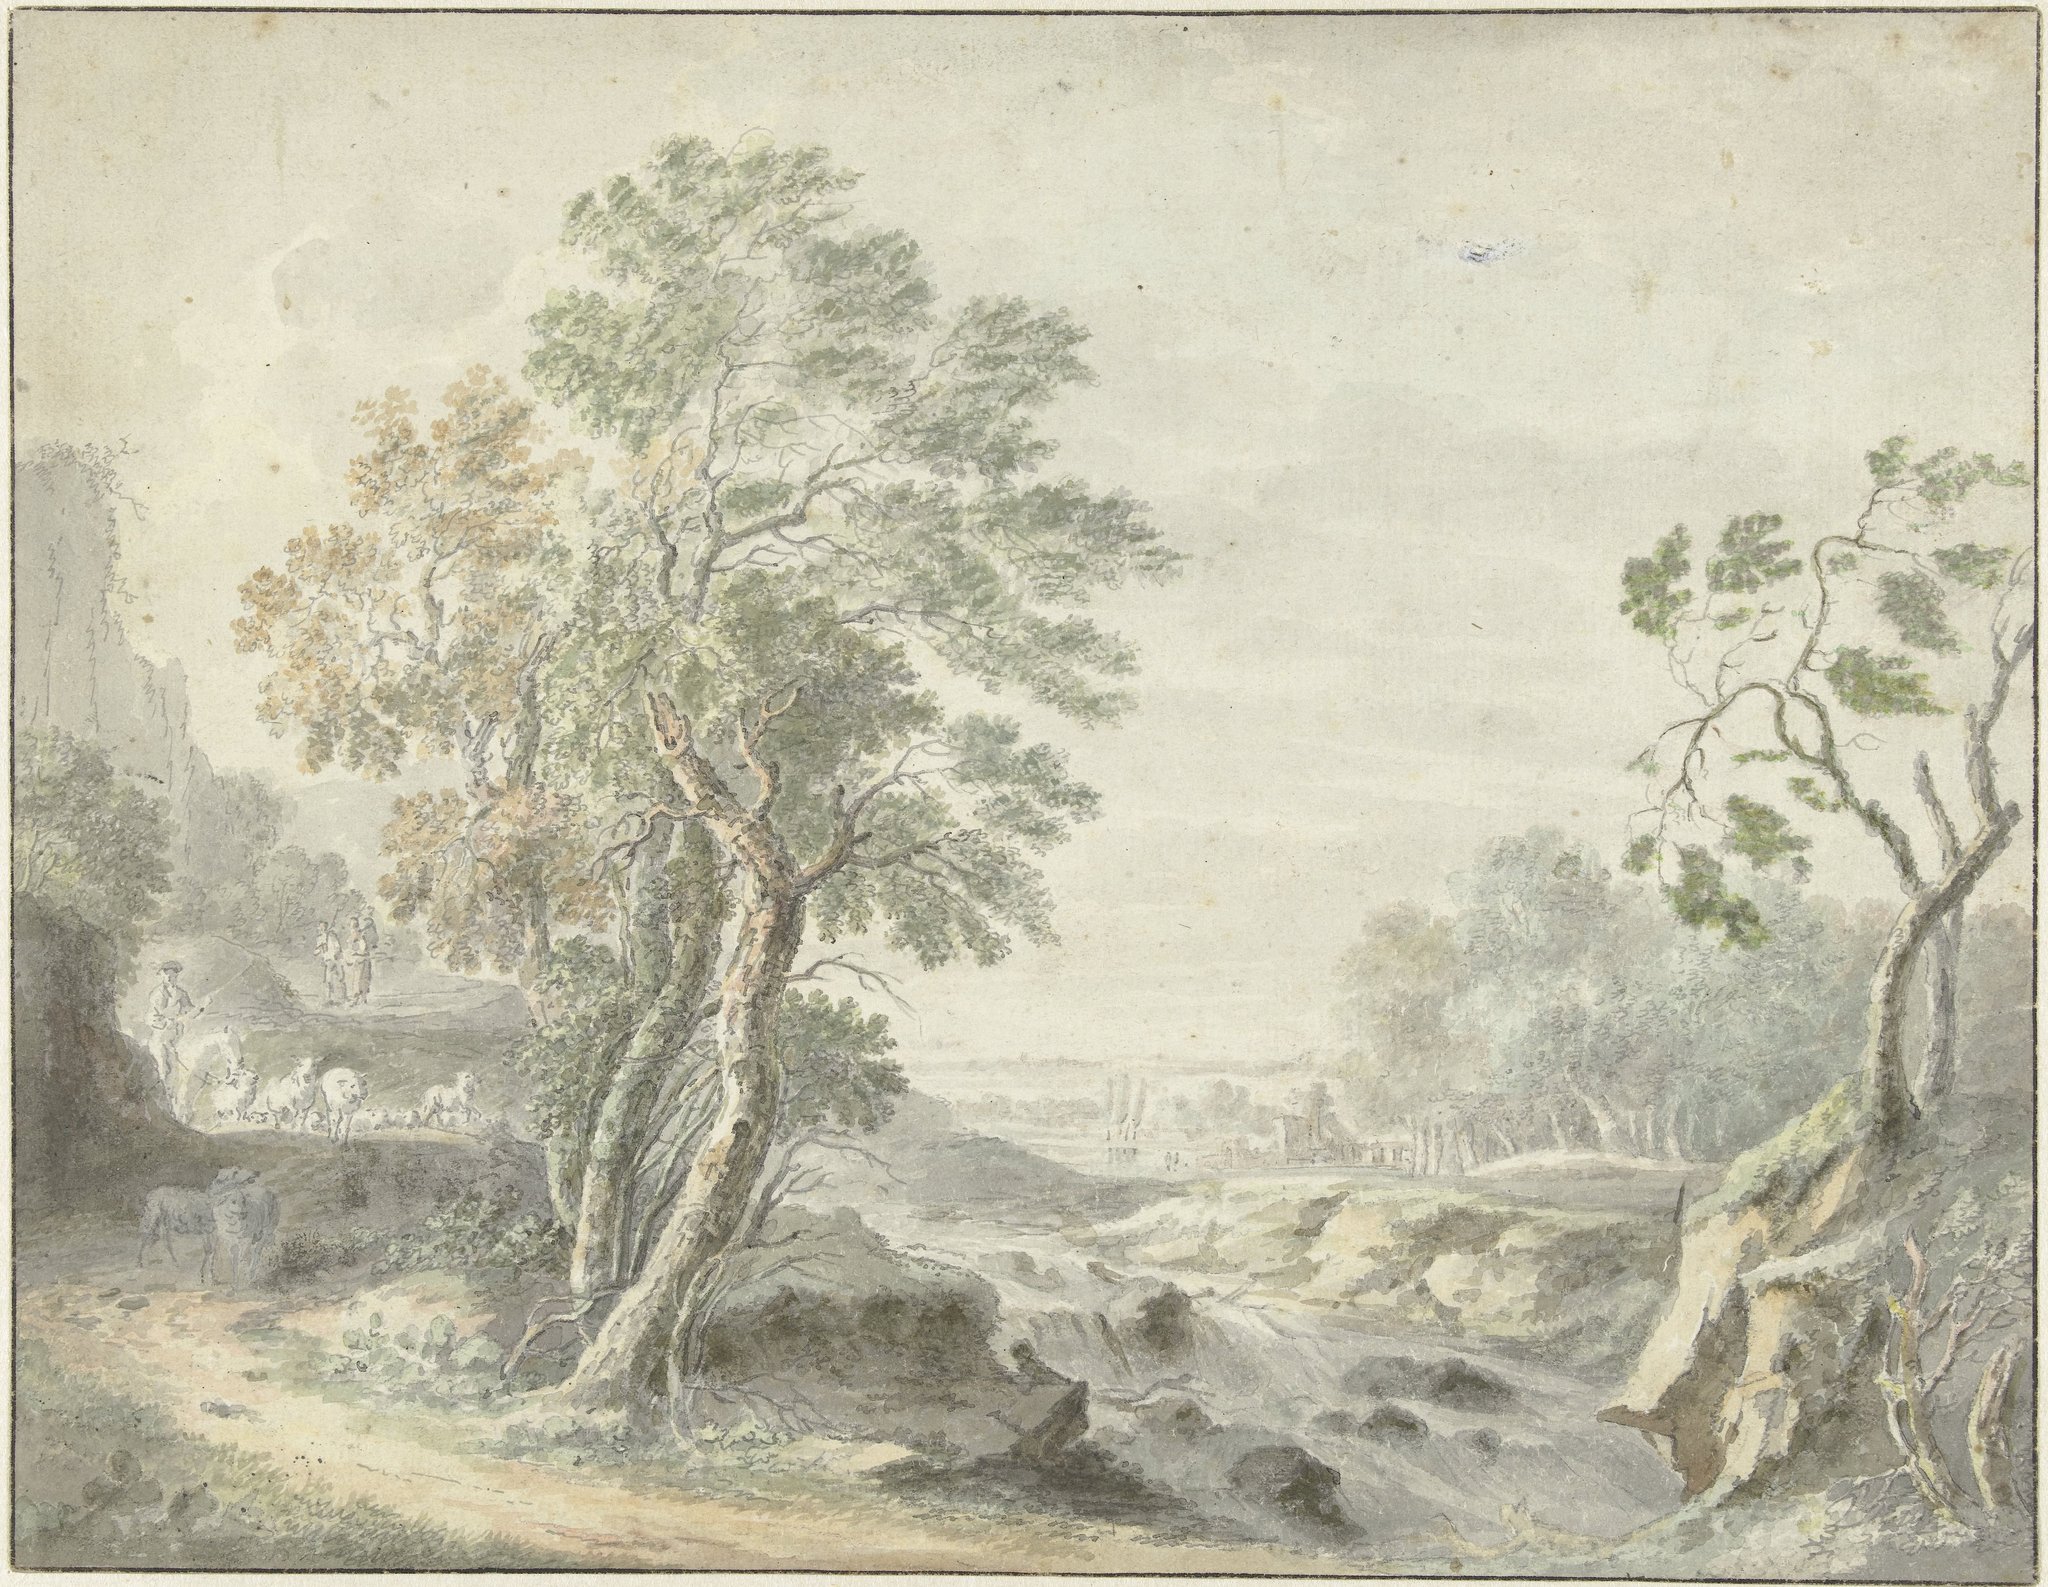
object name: watercolor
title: Italiaans landschap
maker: Anonymous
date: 1700-1800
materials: ink, paper, pencil, watercolor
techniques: brush, pen